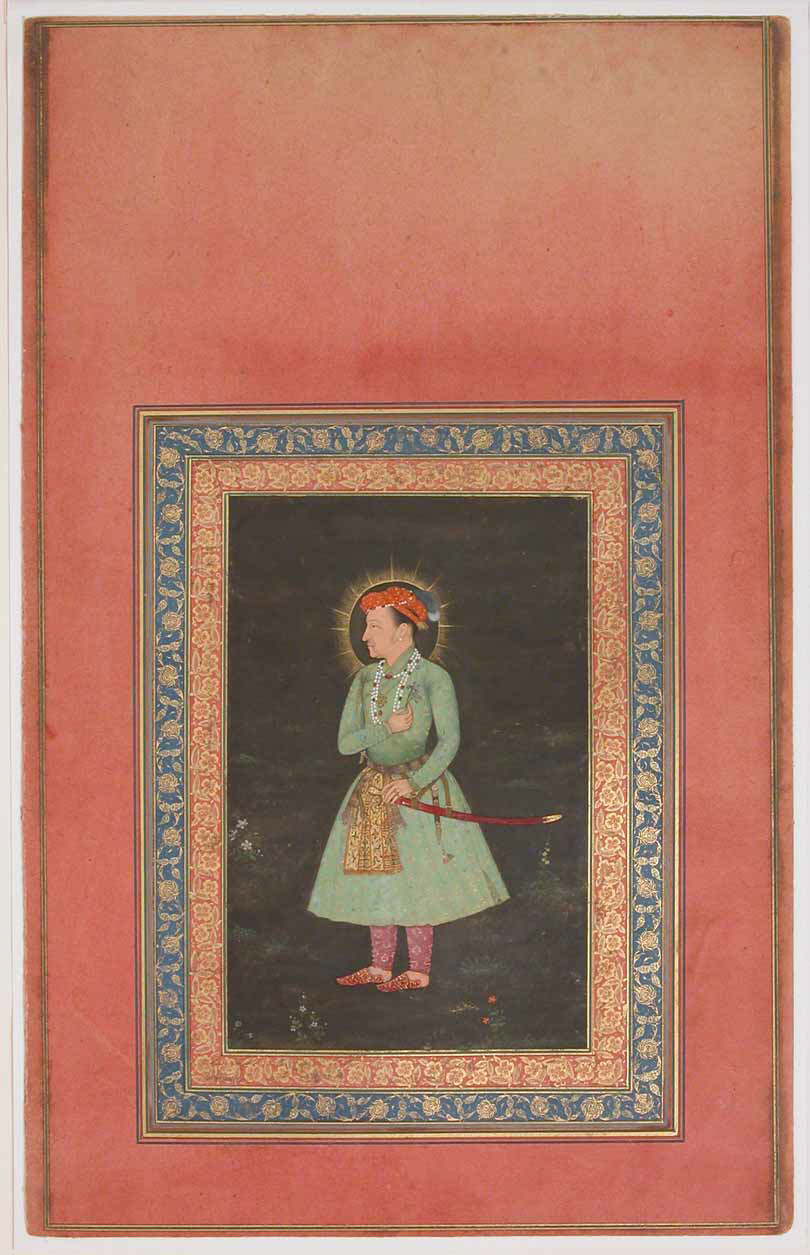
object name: illustrated album leaf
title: "Portrait of Jahangir Holding Flower", Folio from the Davis Album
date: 1651-1700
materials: gold, ink, paper, watercolor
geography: india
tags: swords,men,portraits,flowers